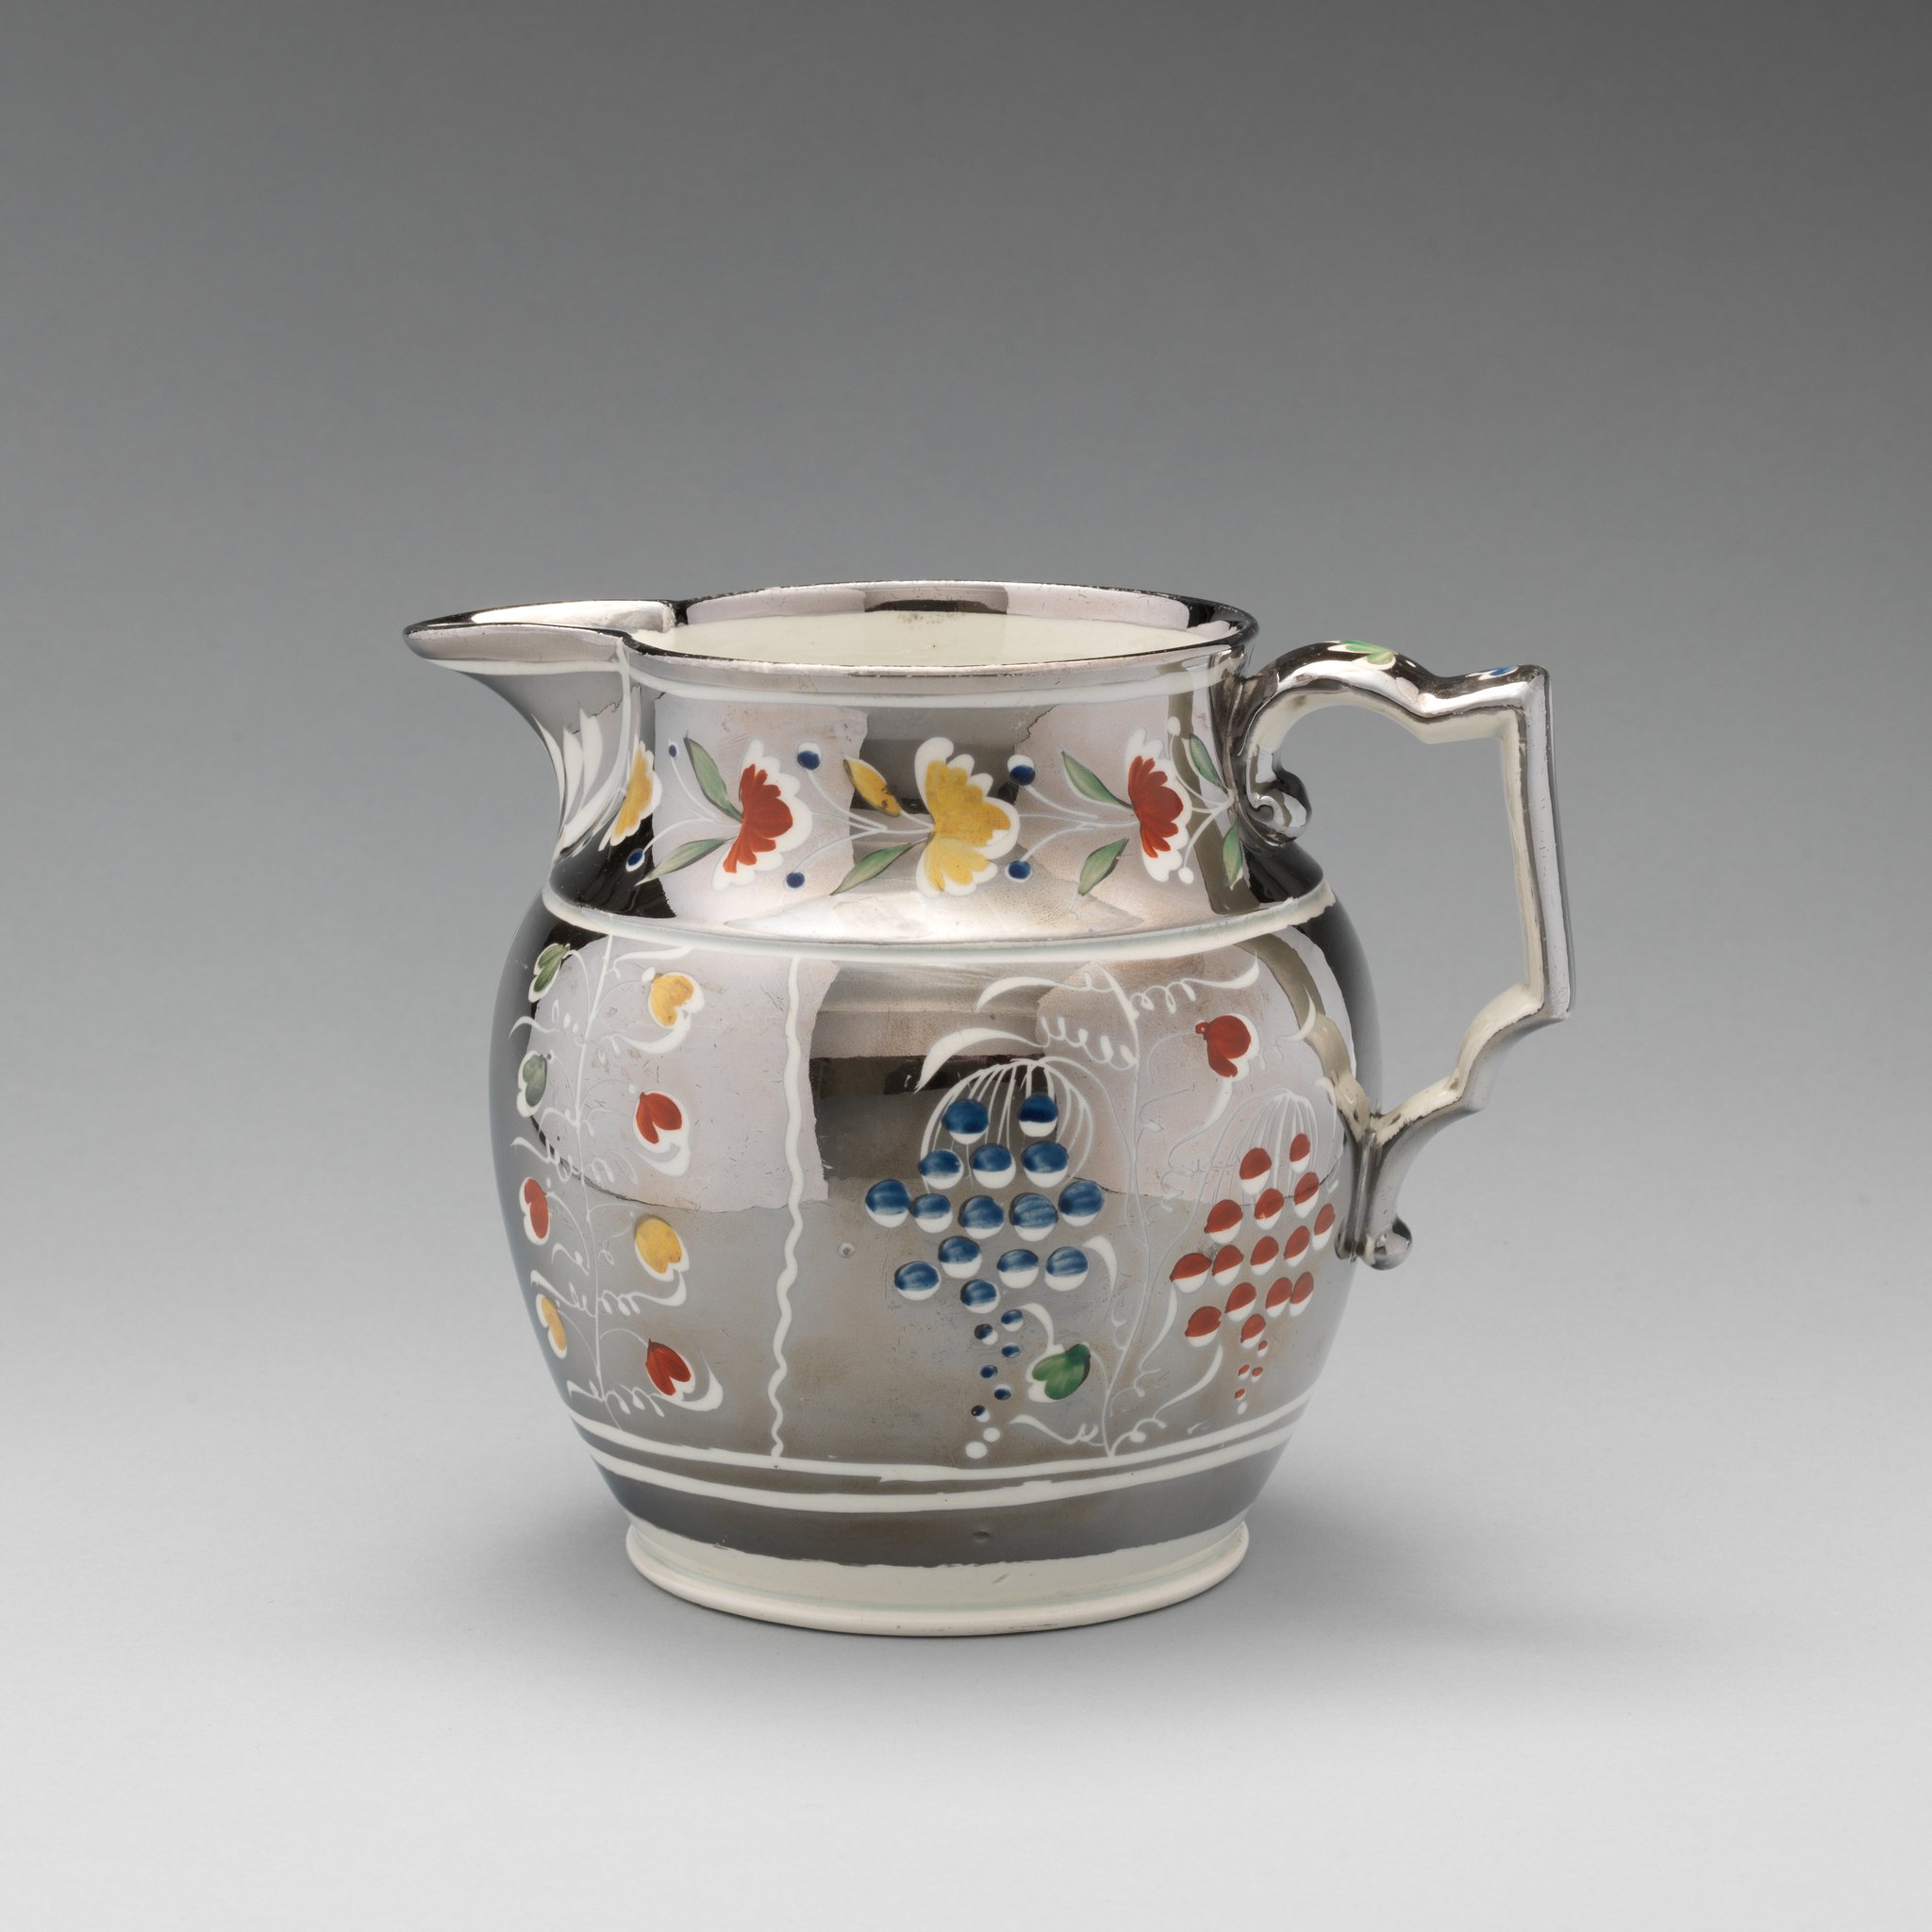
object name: jug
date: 1801-1833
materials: pottery